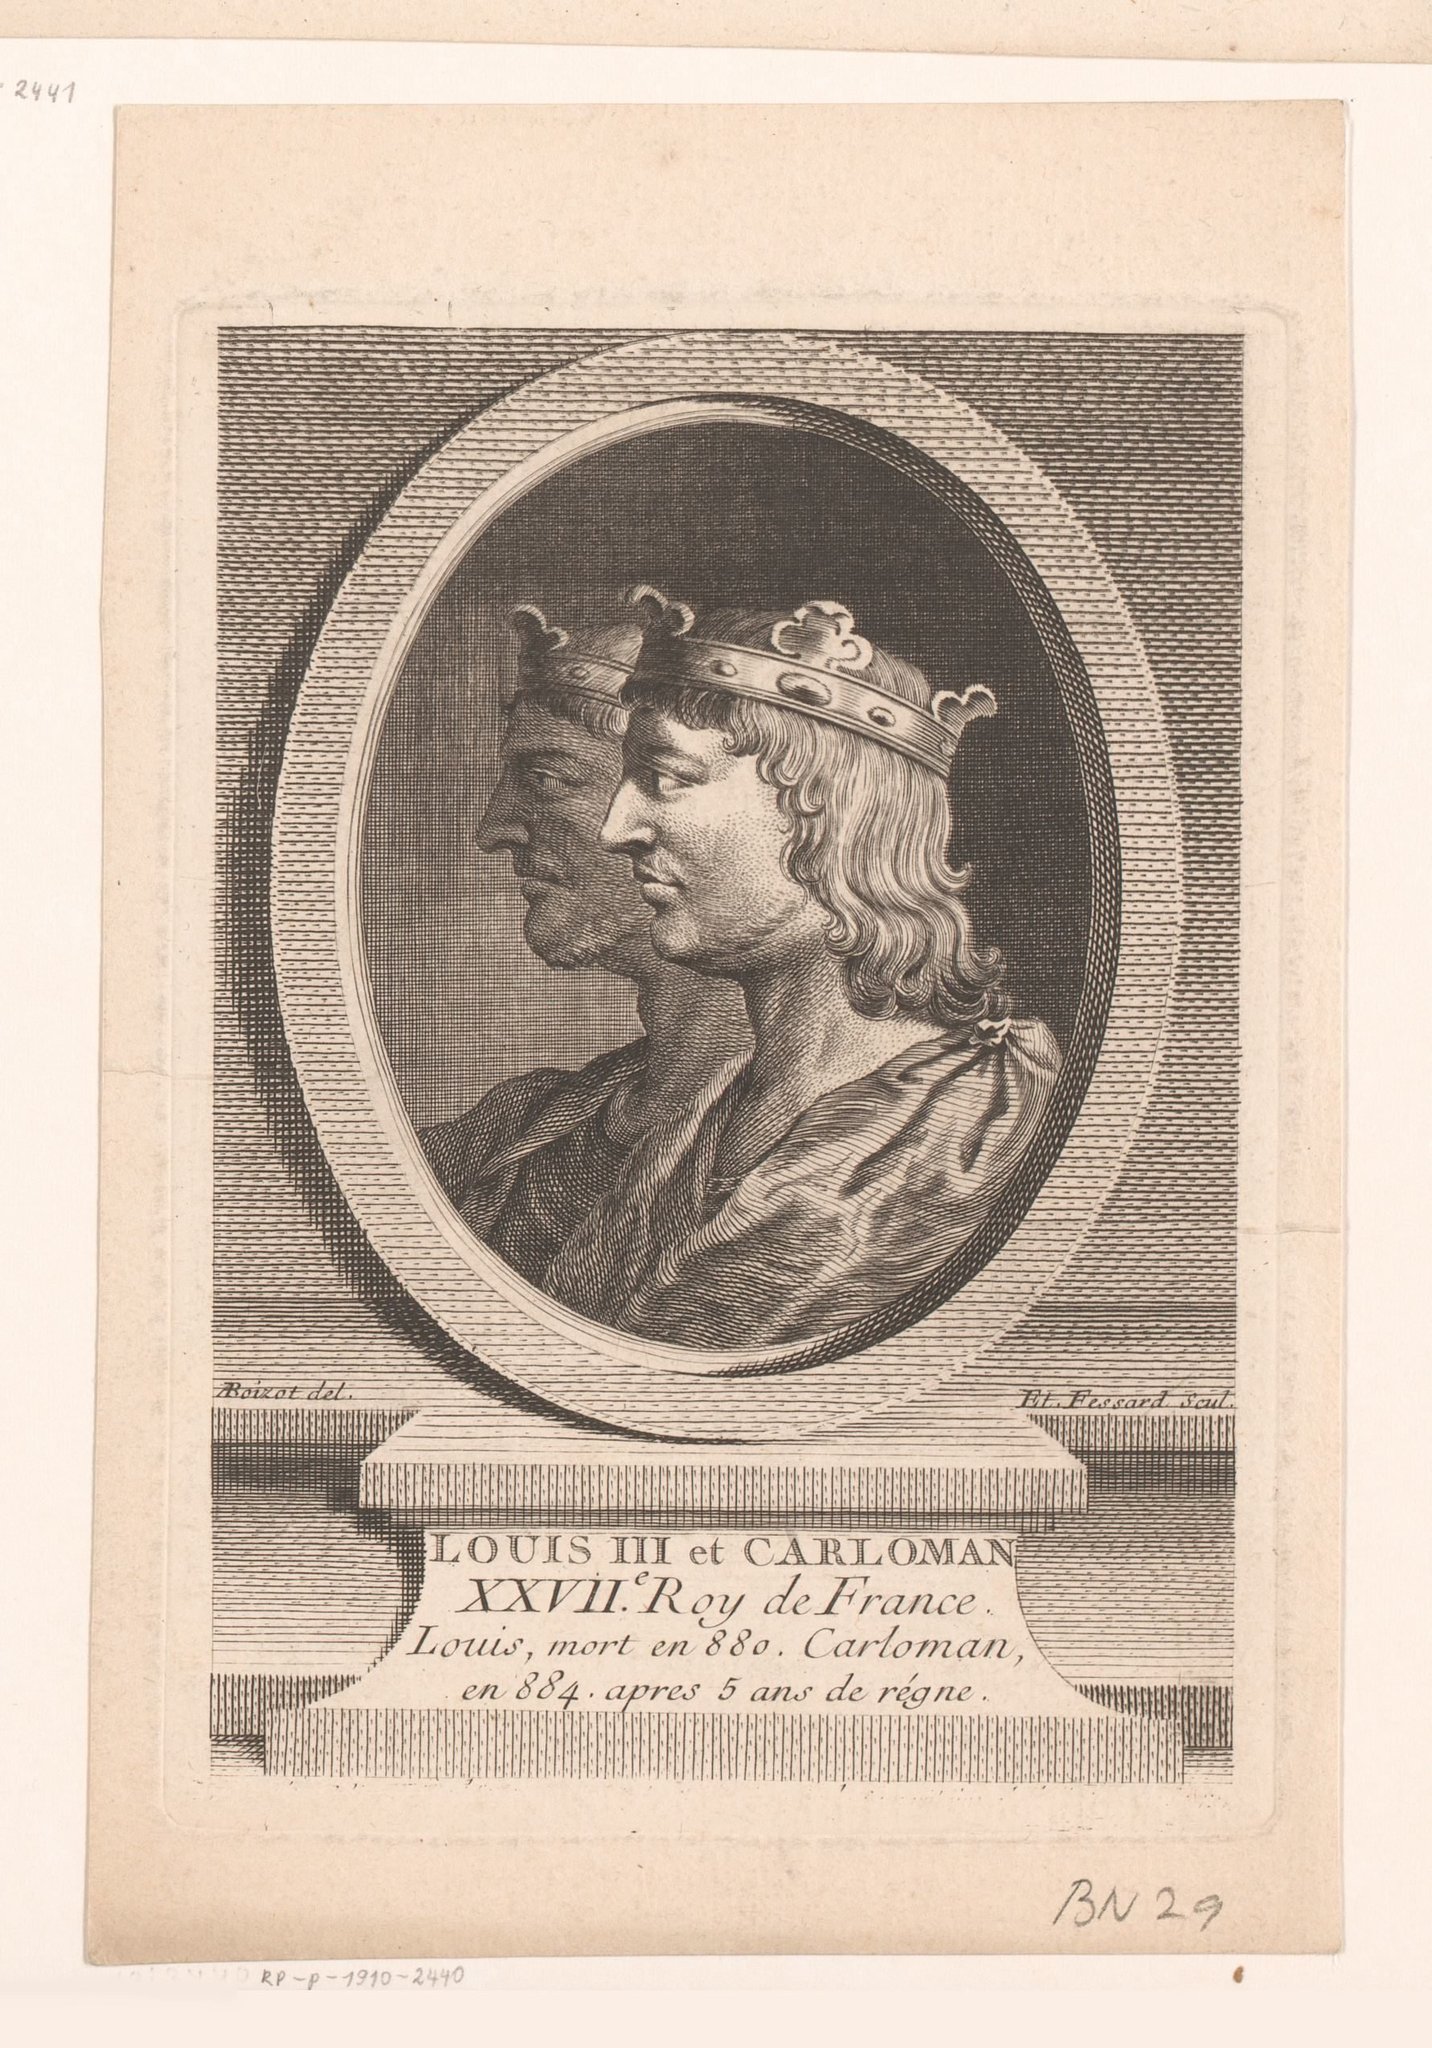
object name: print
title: Portret van Lodewijk III van Frankrijk en Karloman II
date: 1741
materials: paper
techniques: engraving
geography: france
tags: ornament ~ medallion, historical persons, ruler, sovereign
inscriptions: collector's mark: Lugt 2228